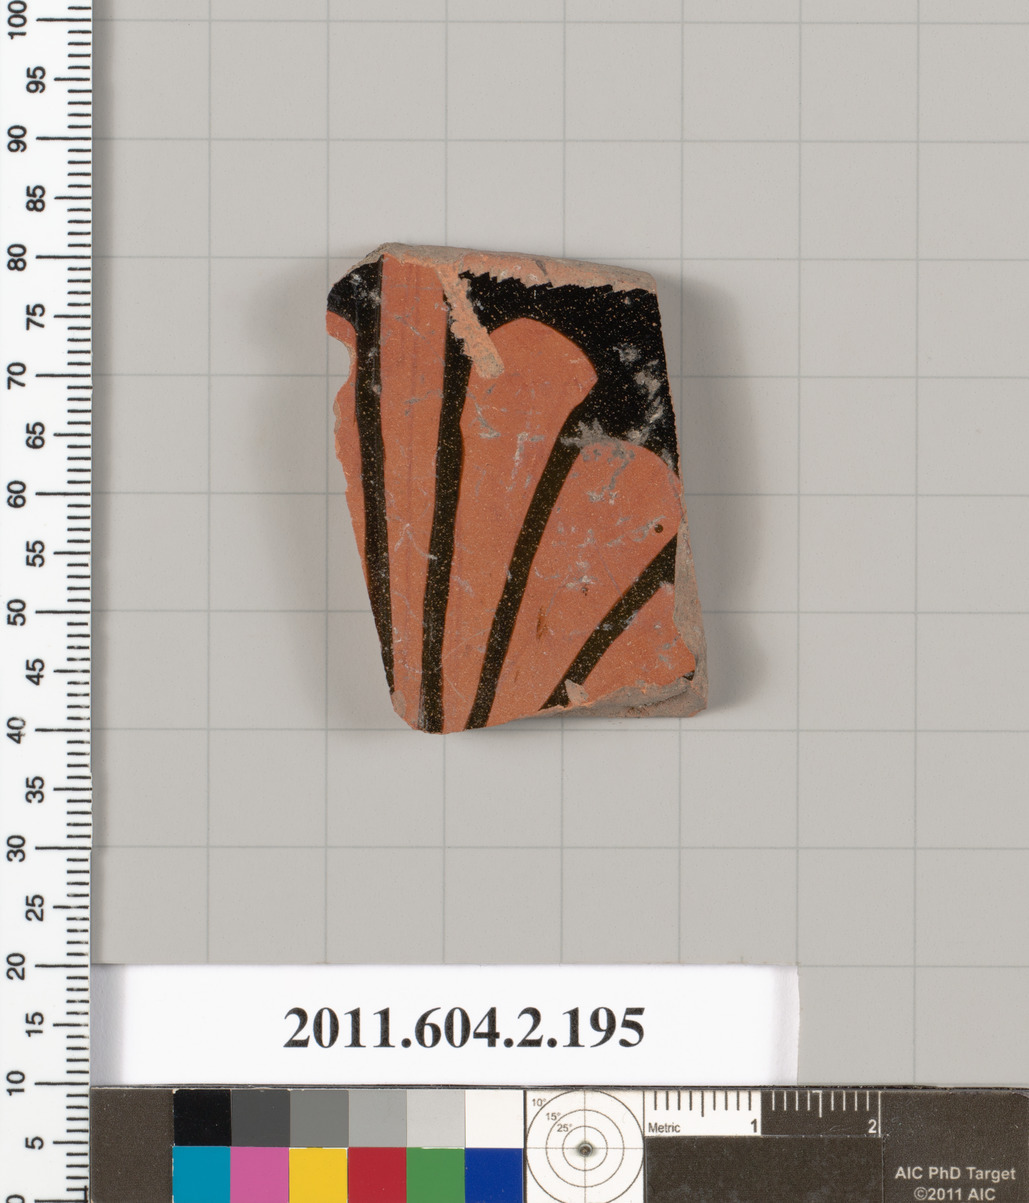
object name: stamnos fragment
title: Terracotta fragment of a stamnos (jar)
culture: greek, attic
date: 475-451 BCE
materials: terracotta